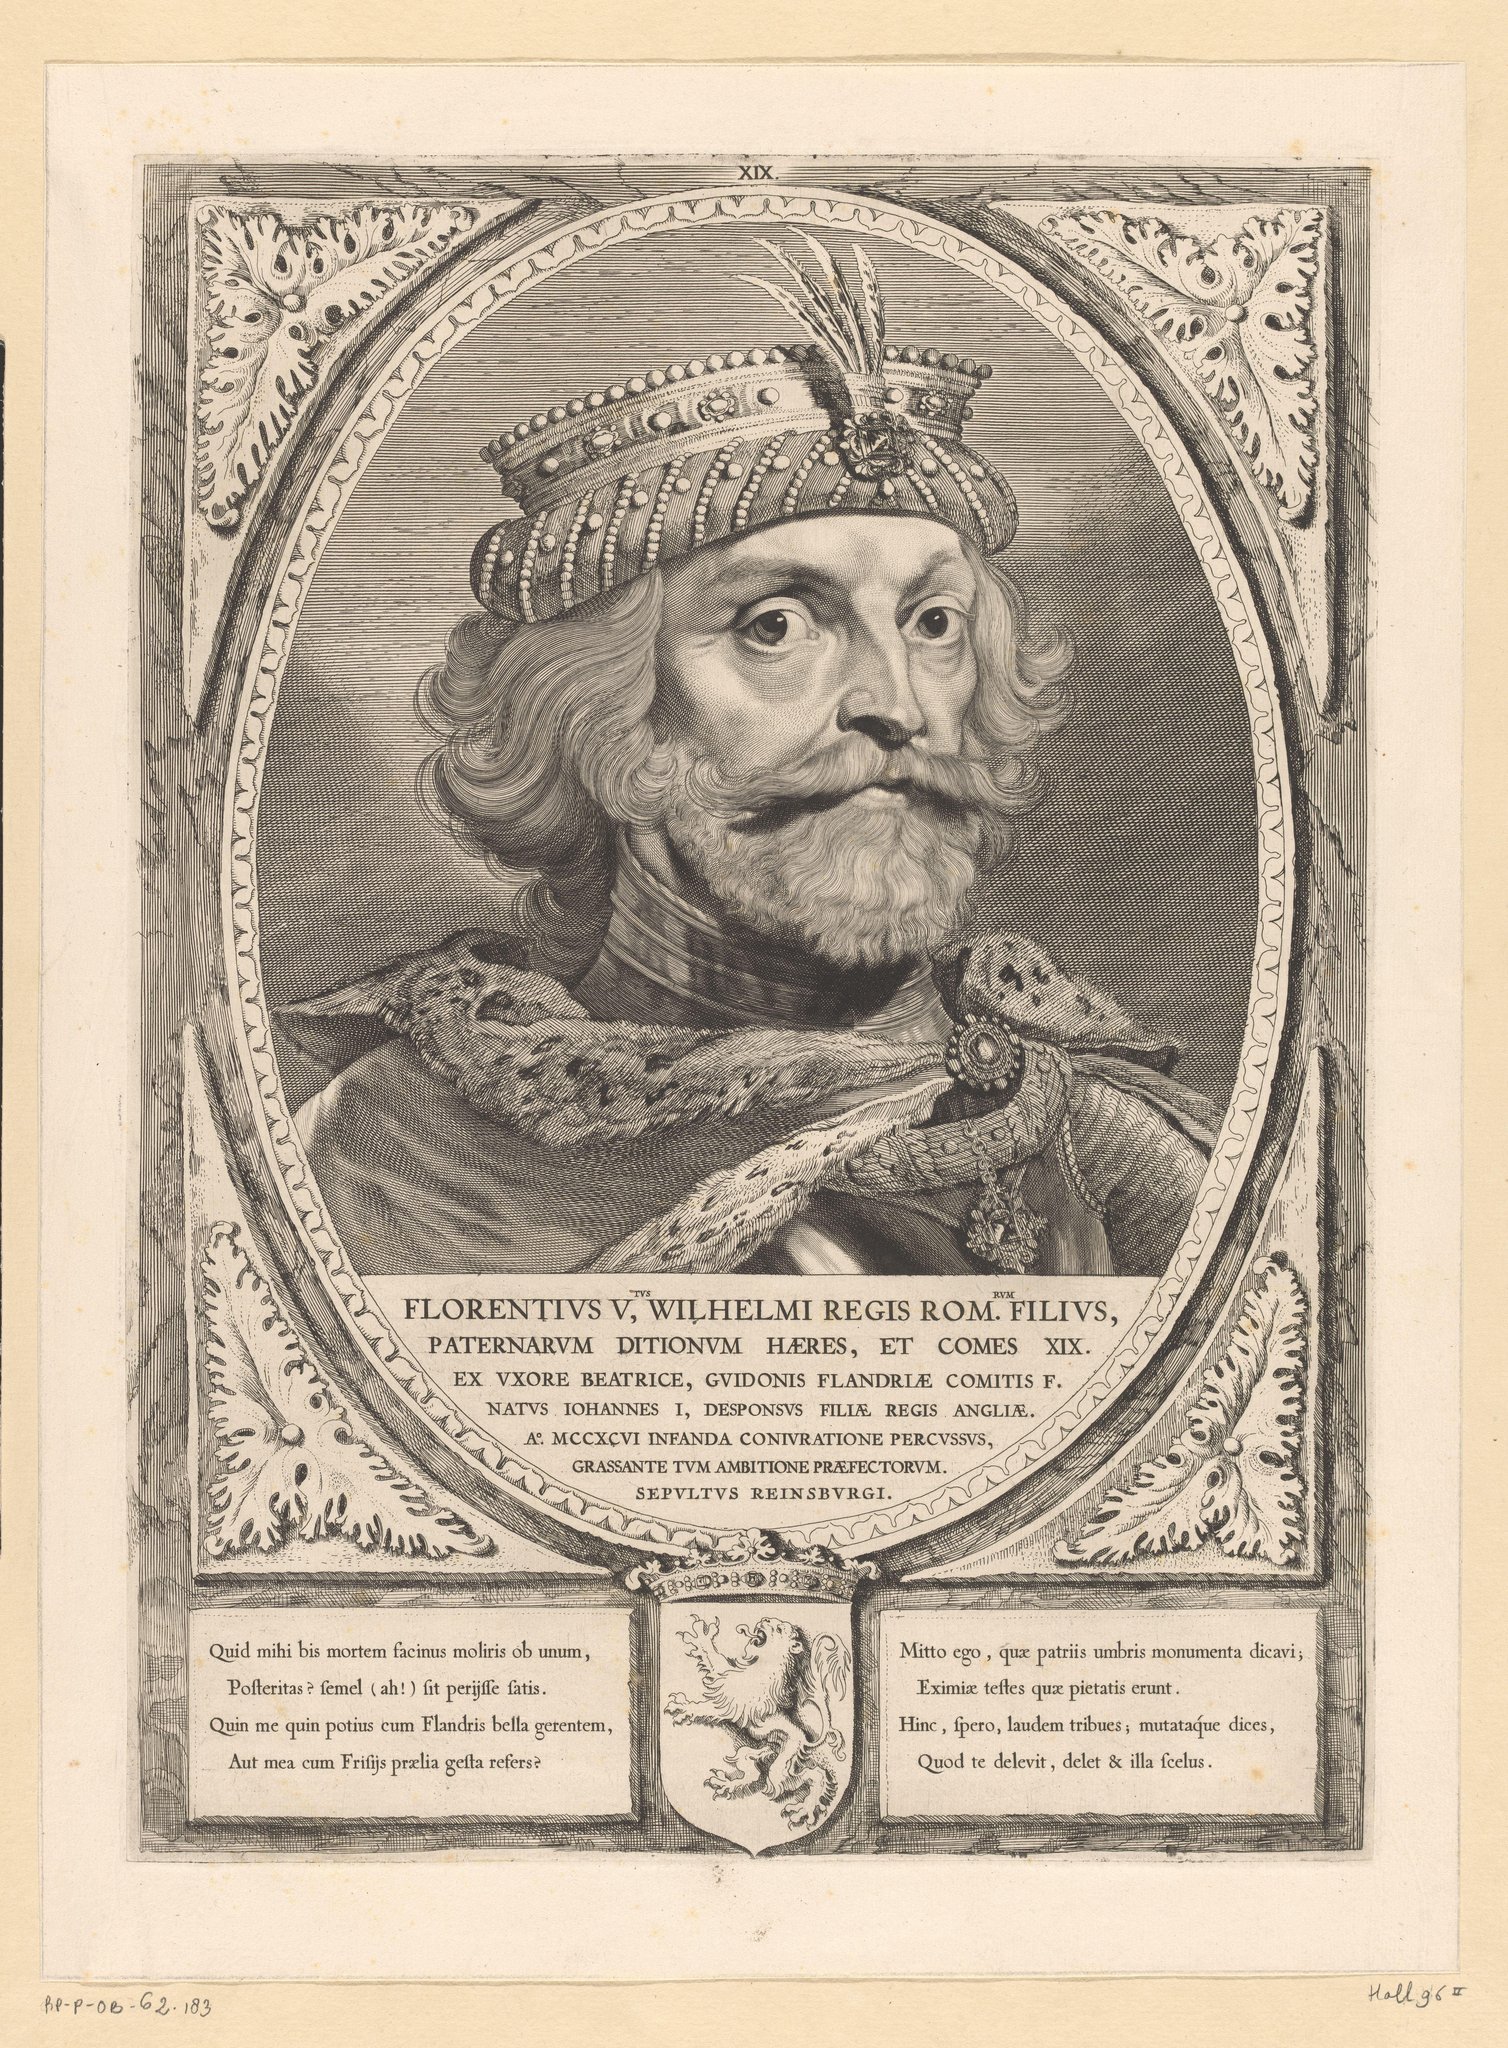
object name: print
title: Portret van Floris V, graaf van Holland en Zeeland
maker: cornelis visscher (ii)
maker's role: draughtsman, painter, print maker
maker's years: 1628-1658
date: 1650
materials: paper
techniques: engraving, etching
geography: haarlem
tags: leiden, floris v (graaf van holland en zeeland)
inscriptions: collector's mark: Lugt 12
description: Floris V, graaf van Holland en Zeeland, met een met veren, edelstenen en parels verfraaide hoofddeksel. De omlijsting is versierd met het wapen van Holland.